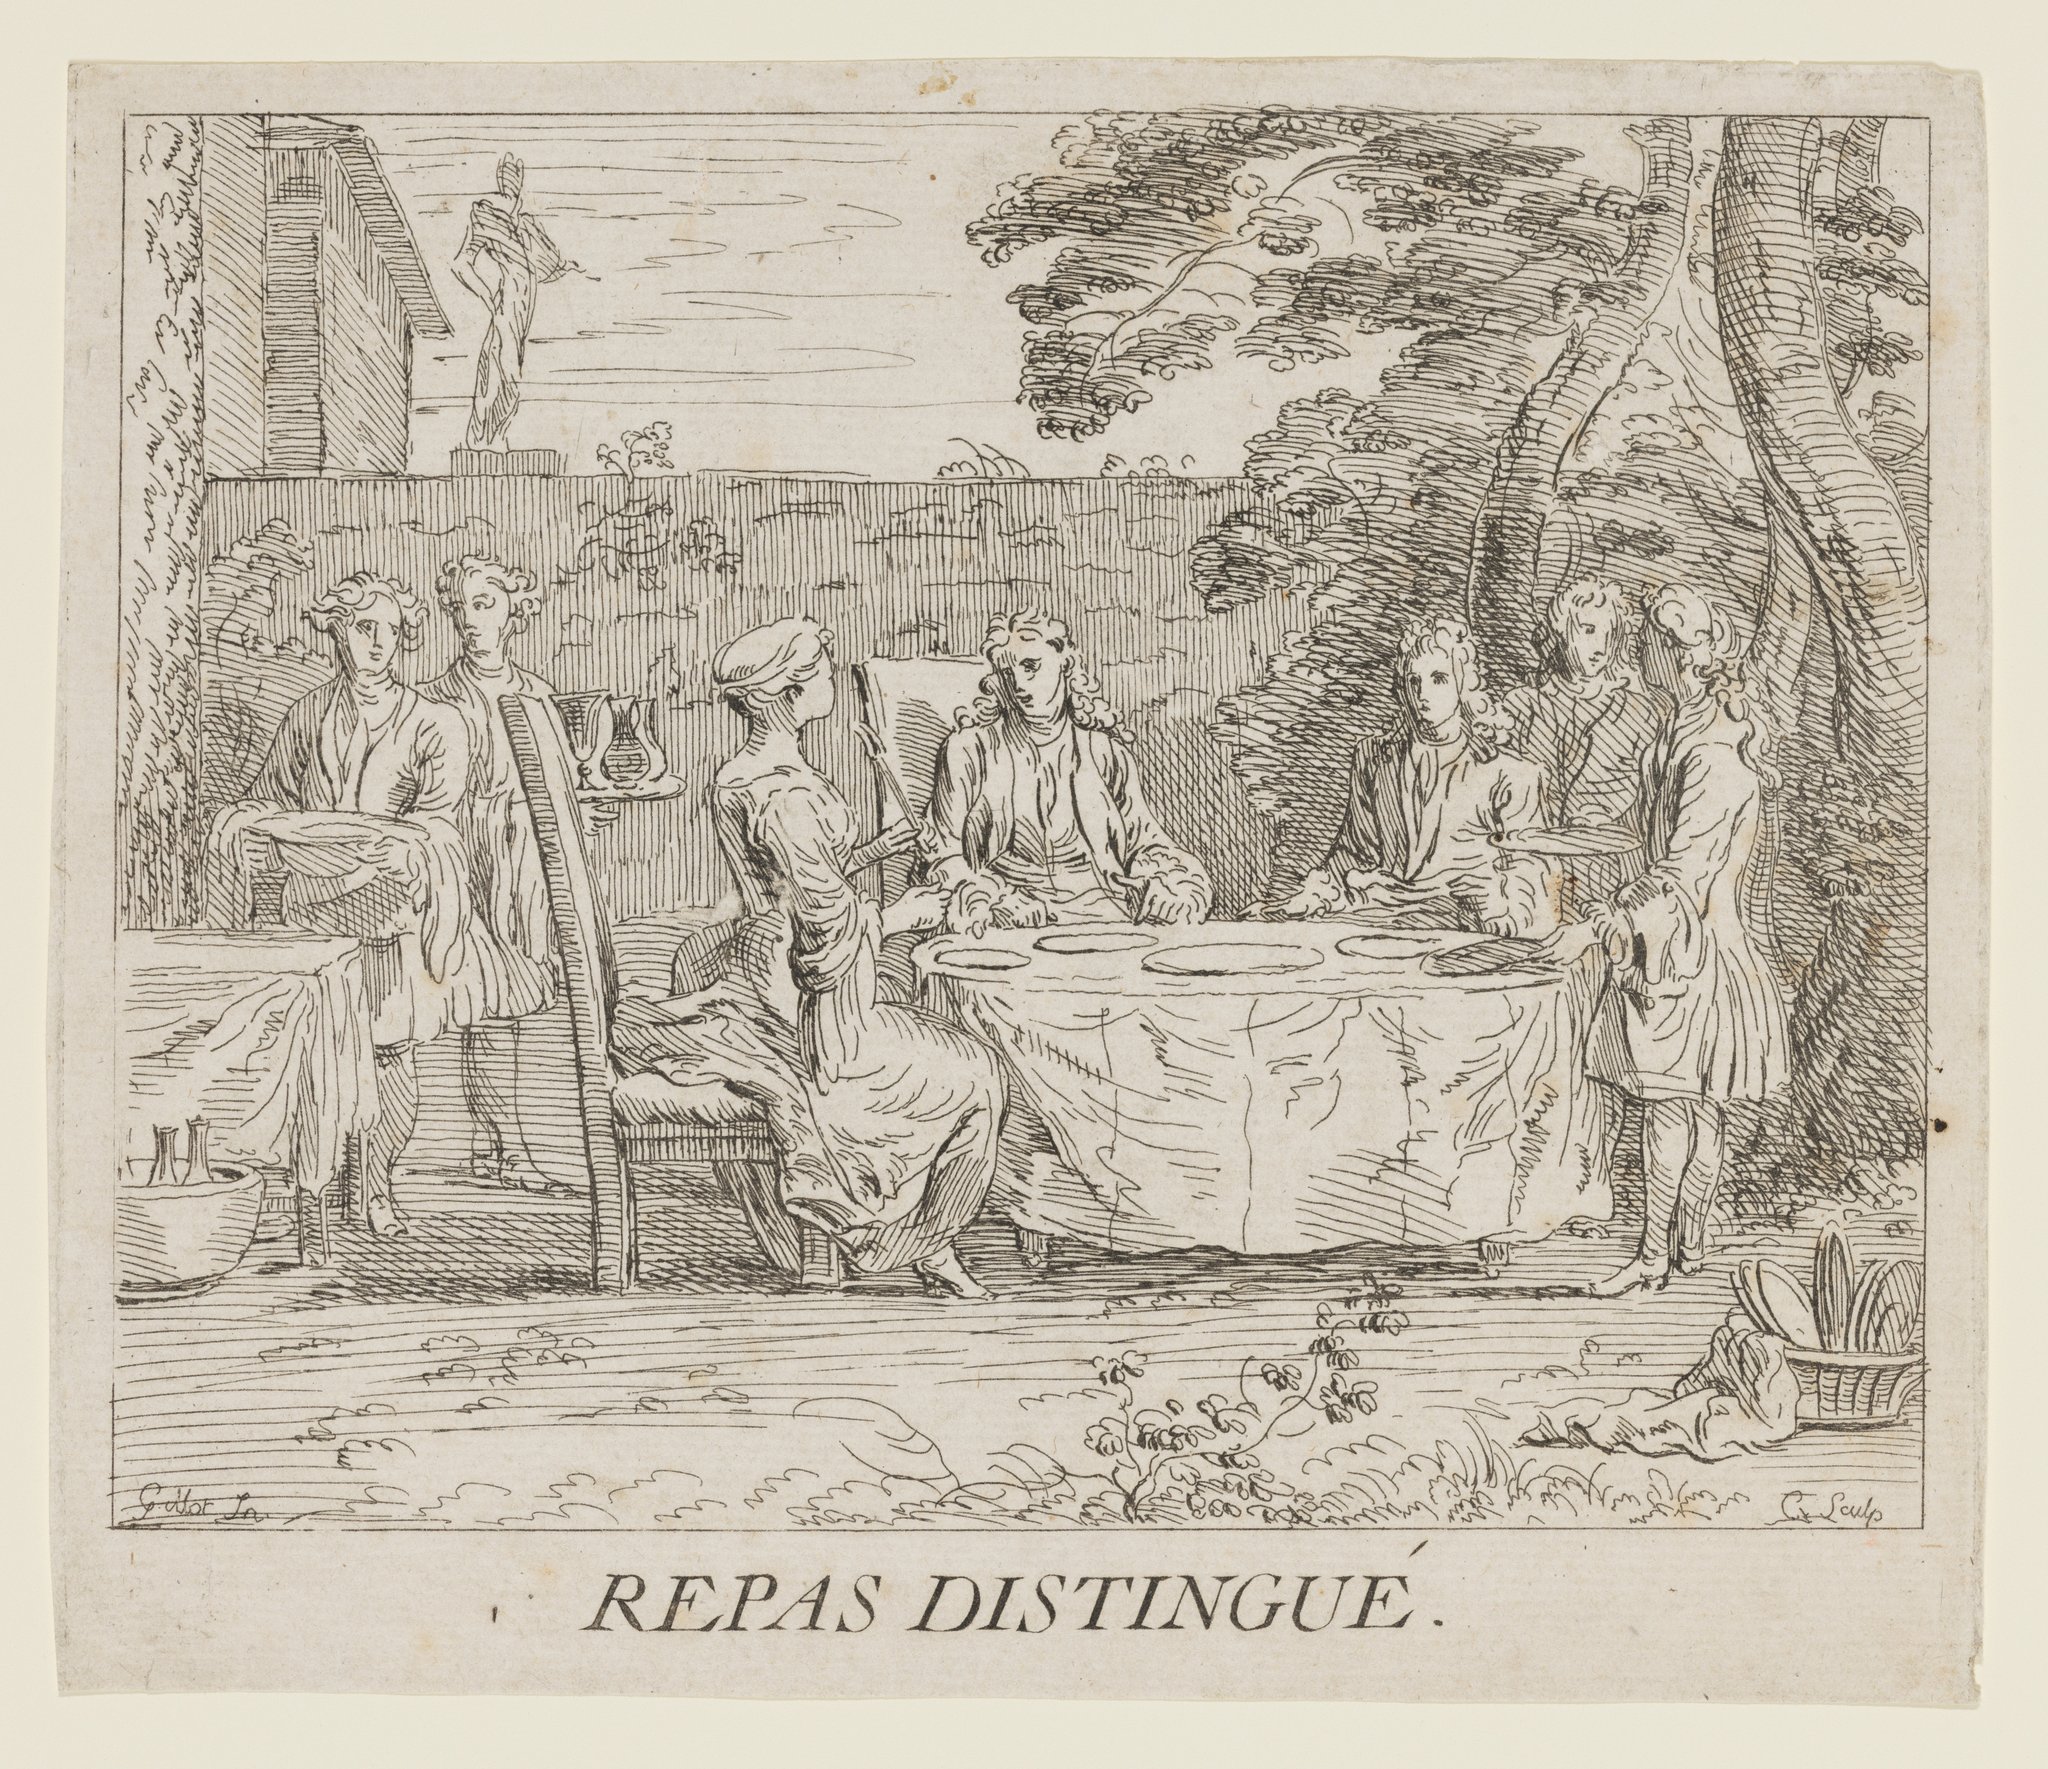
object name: print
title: Elegant Repast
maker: anne claude philippe de tubières, comte de caylus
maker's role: artist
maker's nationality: french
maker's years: 1692-1765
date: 1770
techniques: etching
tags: men,women,dining